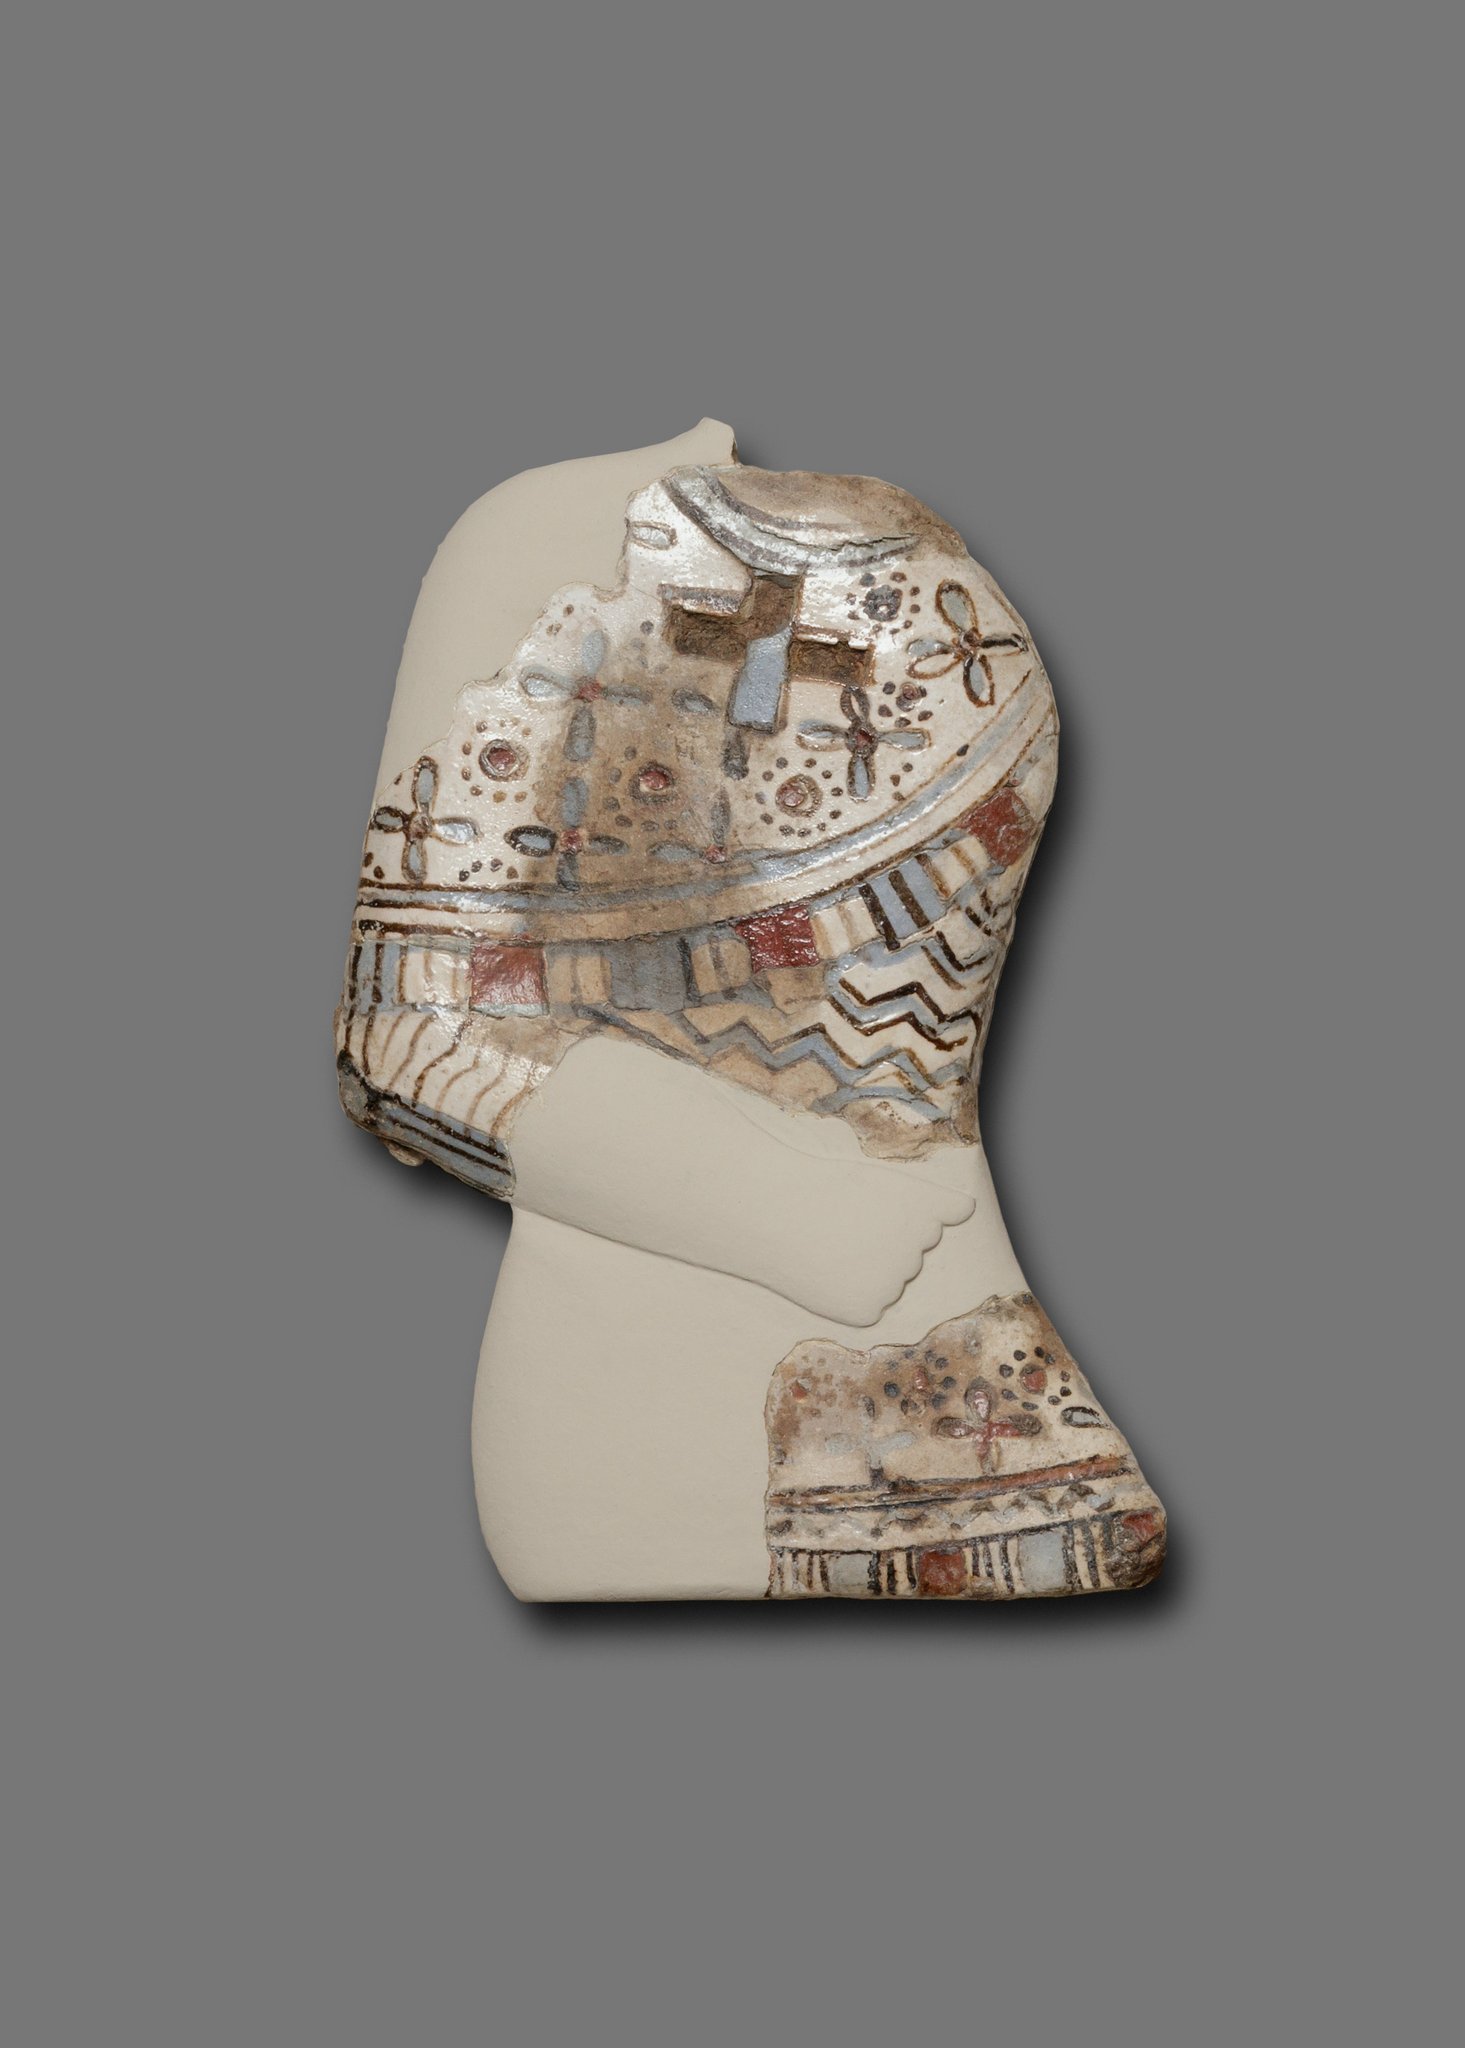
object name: tile inlay, palace of ramesses ii, foreigner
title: Tile Inlay from the Palace of Ramesses II, Torso of a Mesopotamian or Syrian Captive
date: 1279-1213 BCE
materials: faience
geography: egypt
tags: human figures